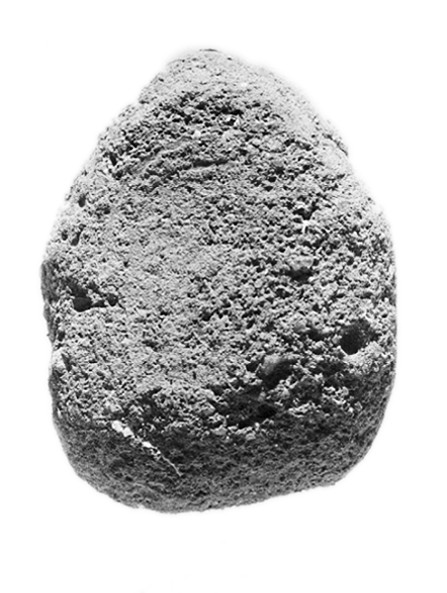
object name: sealing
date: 1981-1640 BCE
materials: mud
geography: egypt